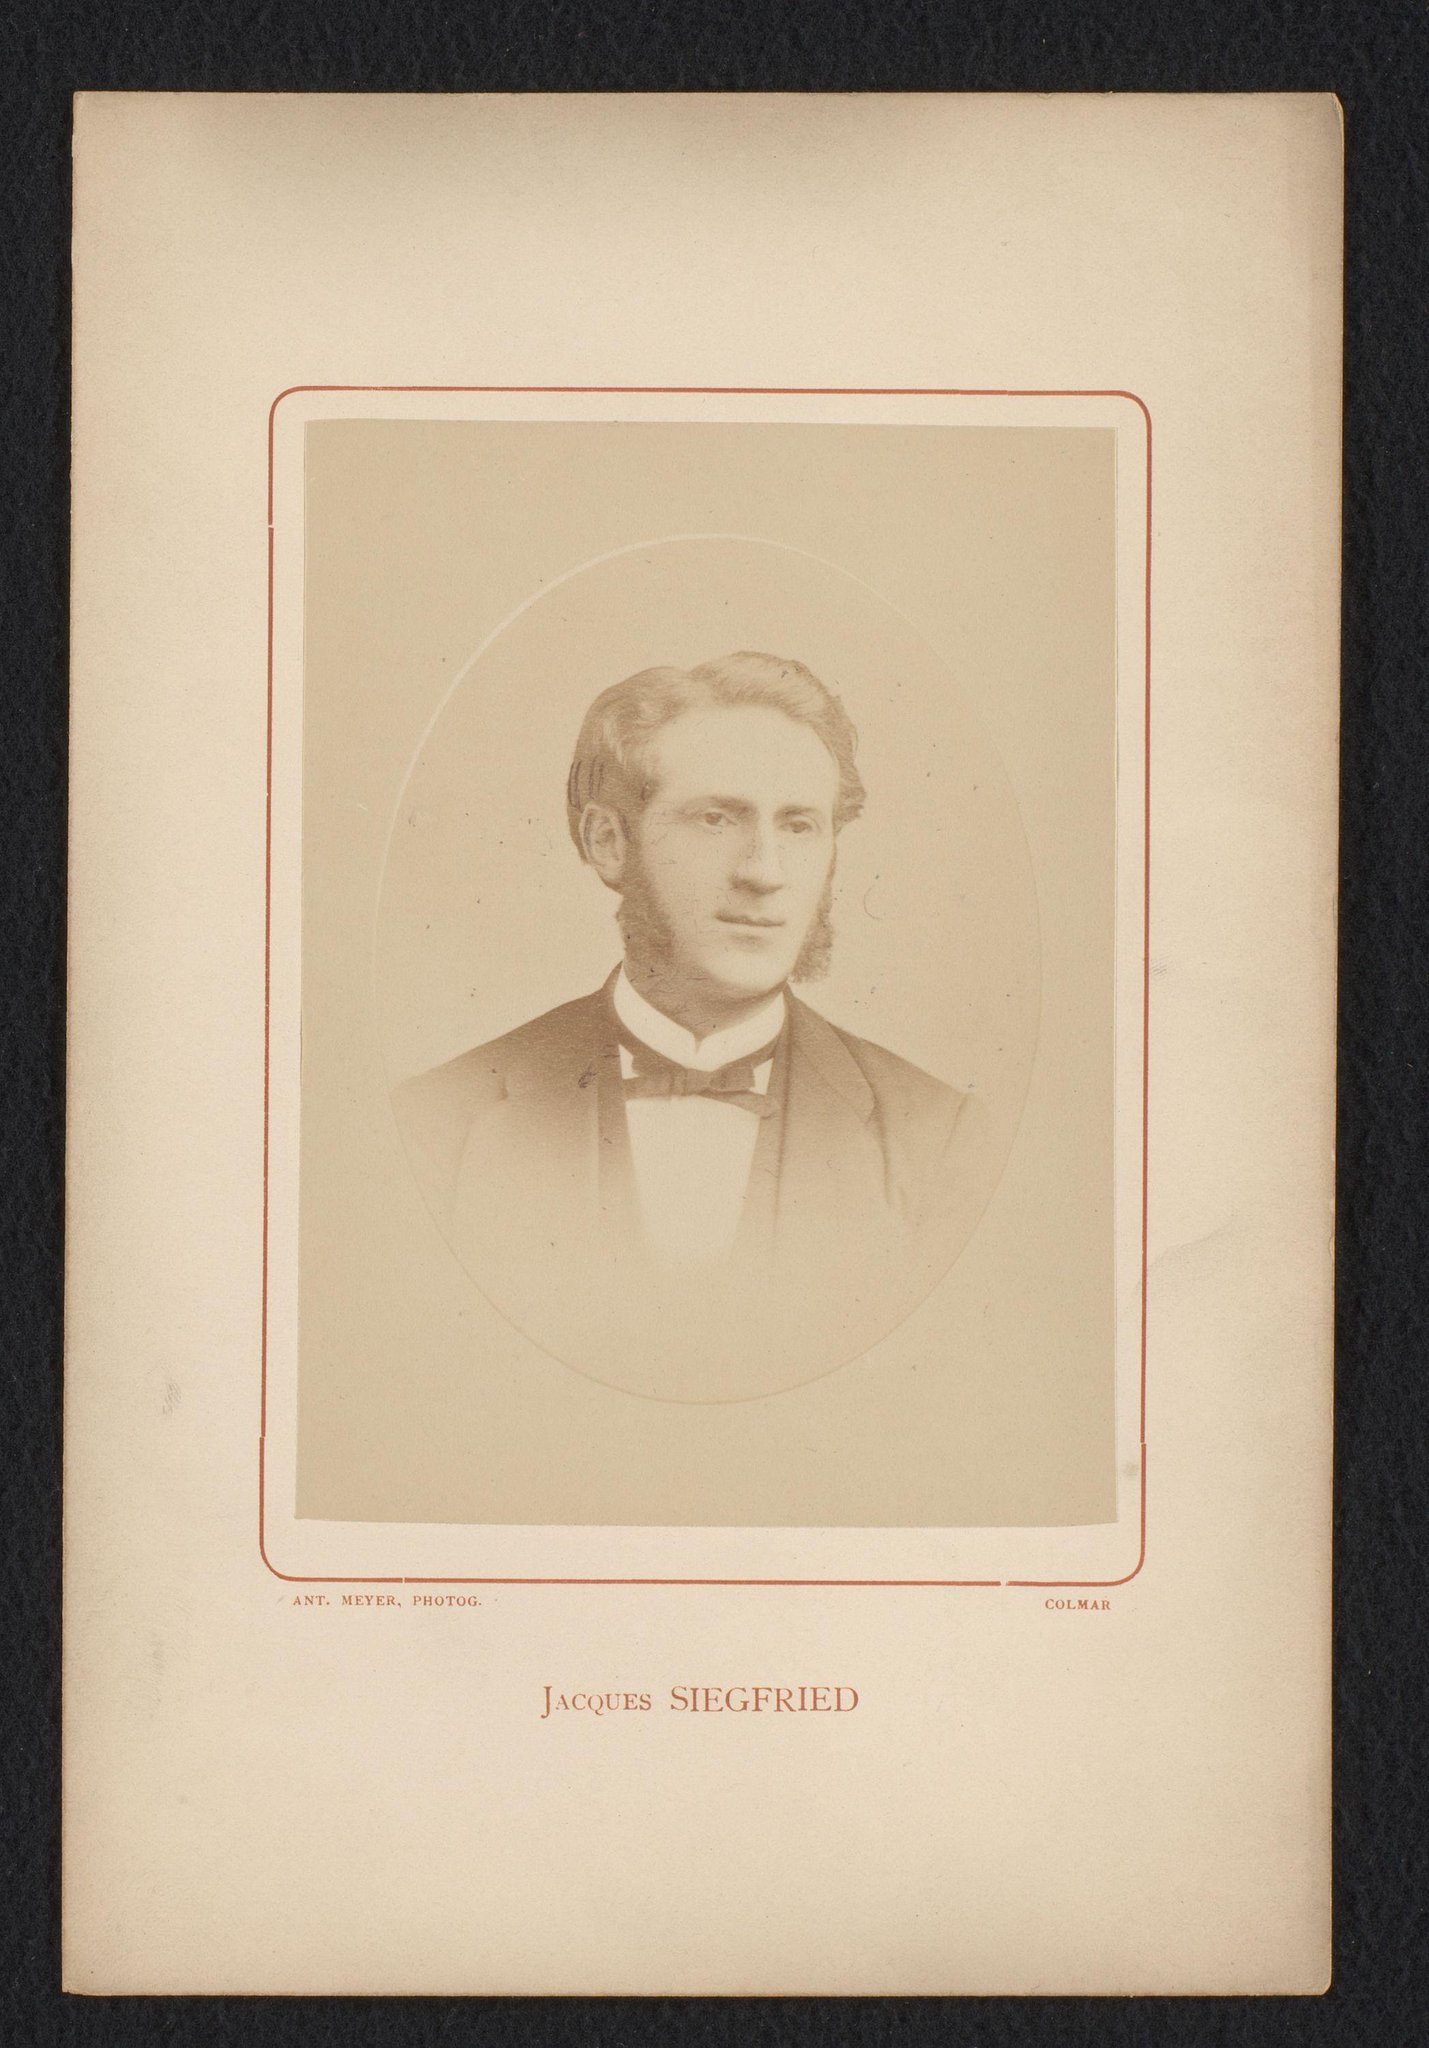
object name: reproduction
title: Jacques Siegfried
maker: anton meyer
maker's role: fotograaf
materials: photographic support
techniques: albumen print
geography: colmar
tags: historical persons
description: Deze foto maakt deel uit van een omslag met 29 foto's op 29 bladen en 23 teksbladen.